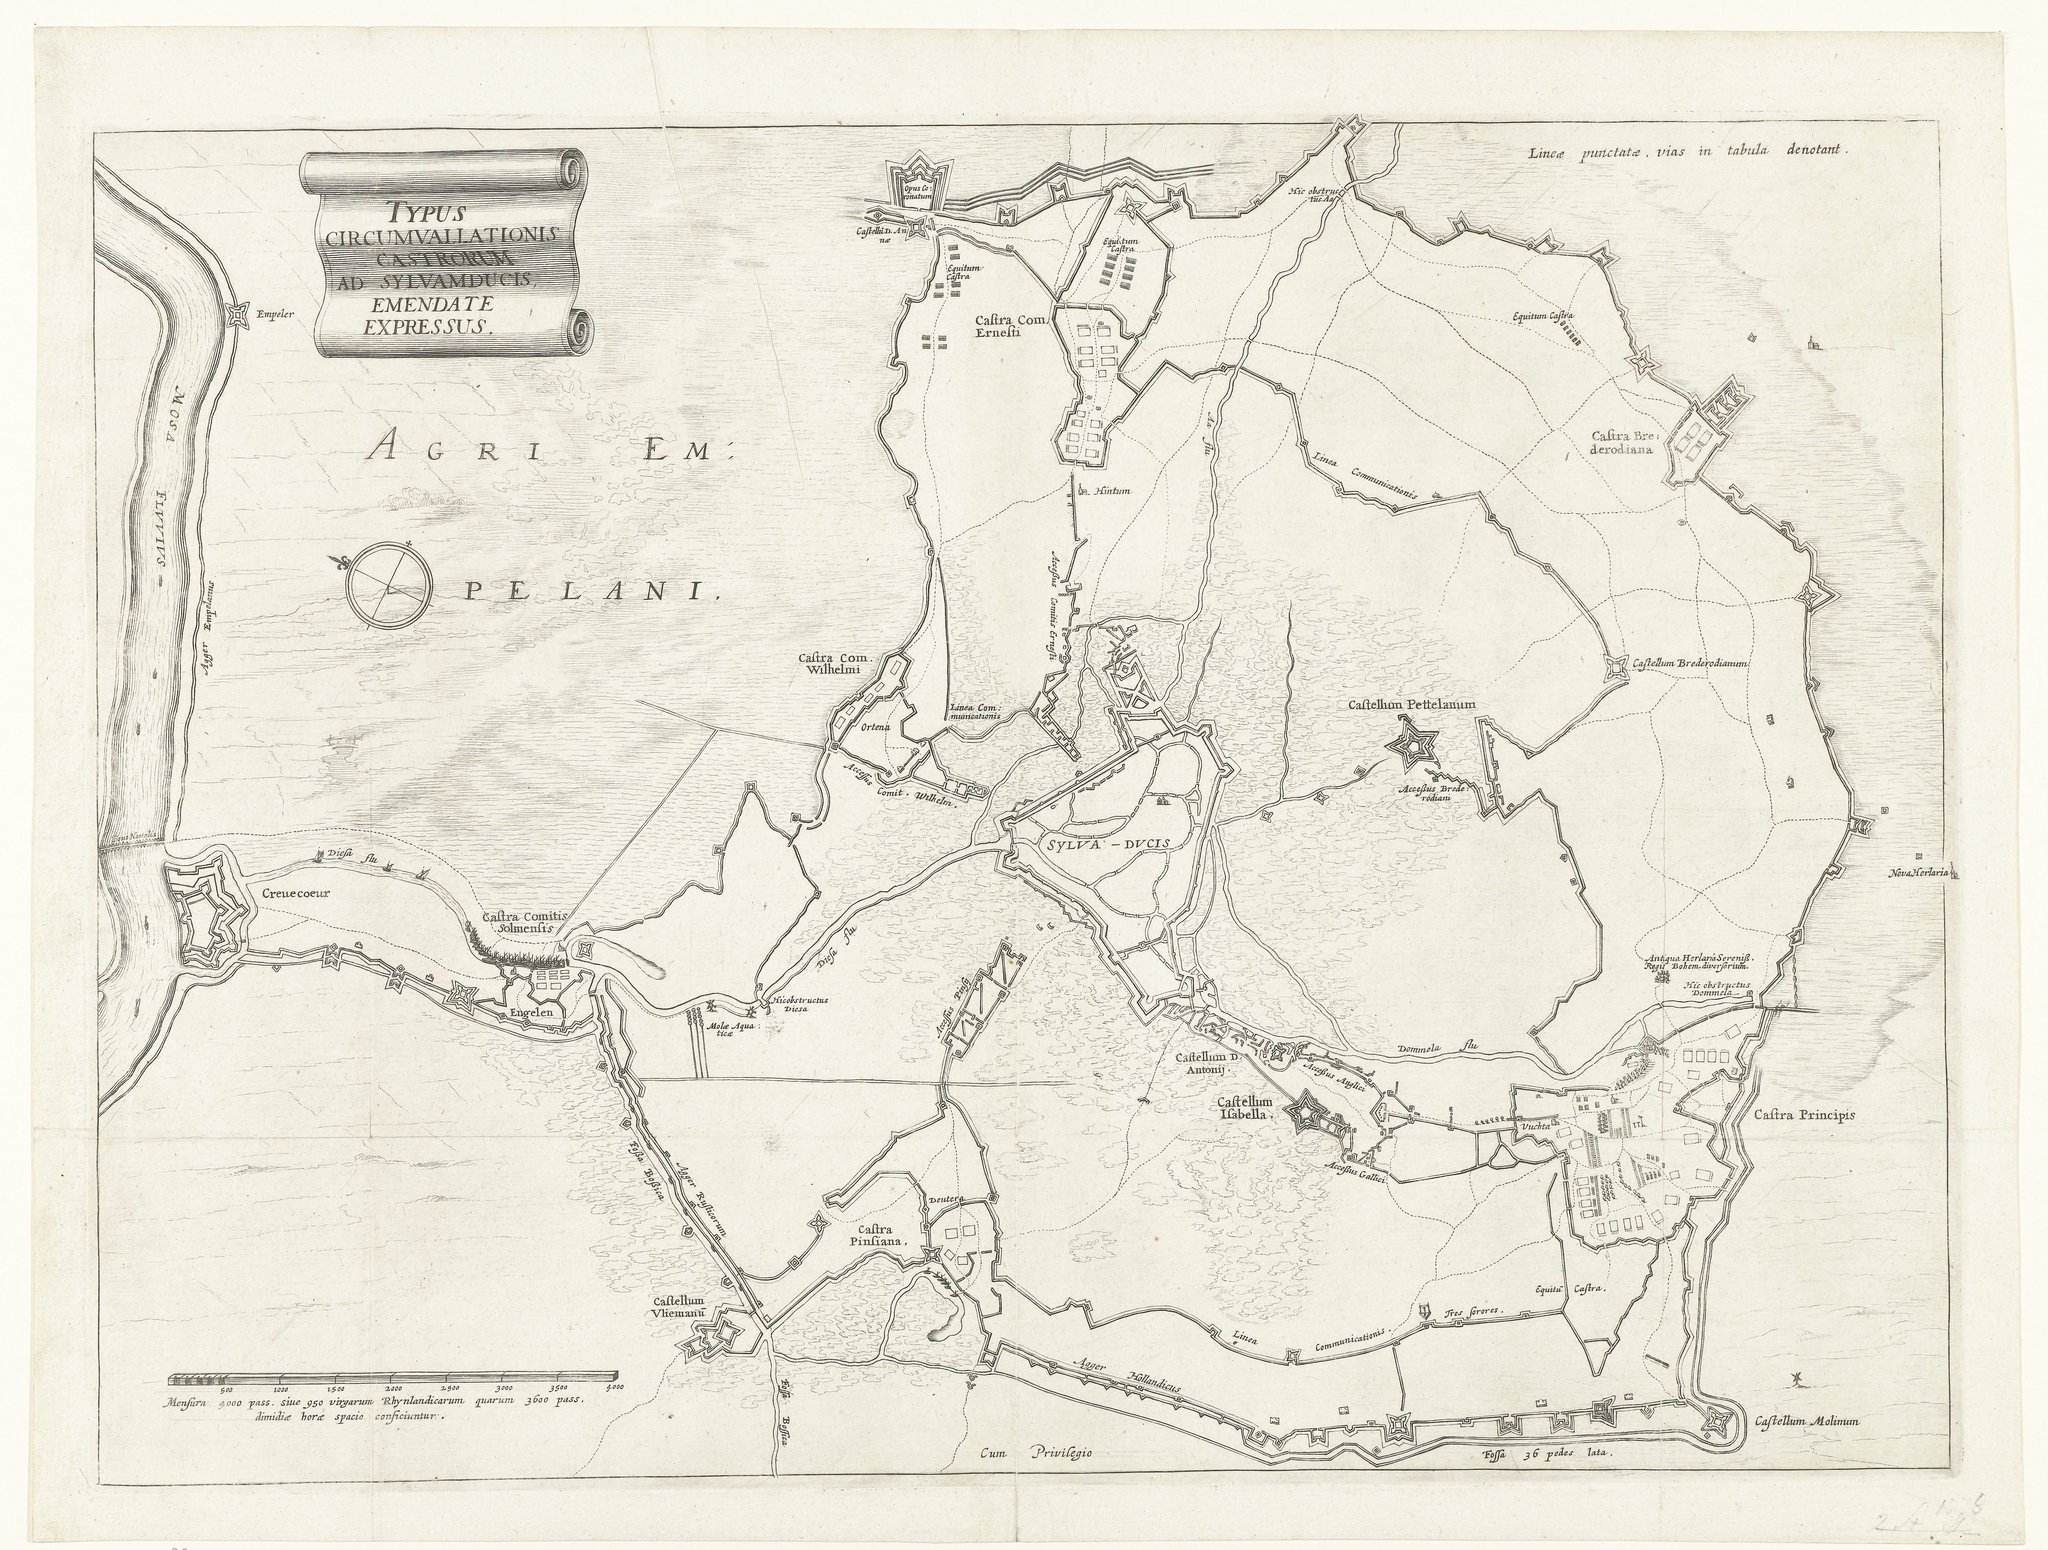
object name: print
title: Omsingeling van Den Bosch tijdens het beleg door Frederik Hendrik, 1629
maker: Anonymous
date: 1629-1631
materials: paper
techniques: etching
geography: northern netherlands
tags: the hague, frederick henry (prince of orange), maps of separate countries or regions, siege, position war, den bosch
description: Kaart van de omsingeling van Den Bosch tijdens het beleg door het Staatse leger onder Frederik Hendrik, van 1 mei tot 17 september 1629. Links het fort Crèvecoeur aan de Maas. Opschriften in de voorstelling in het Latijn.